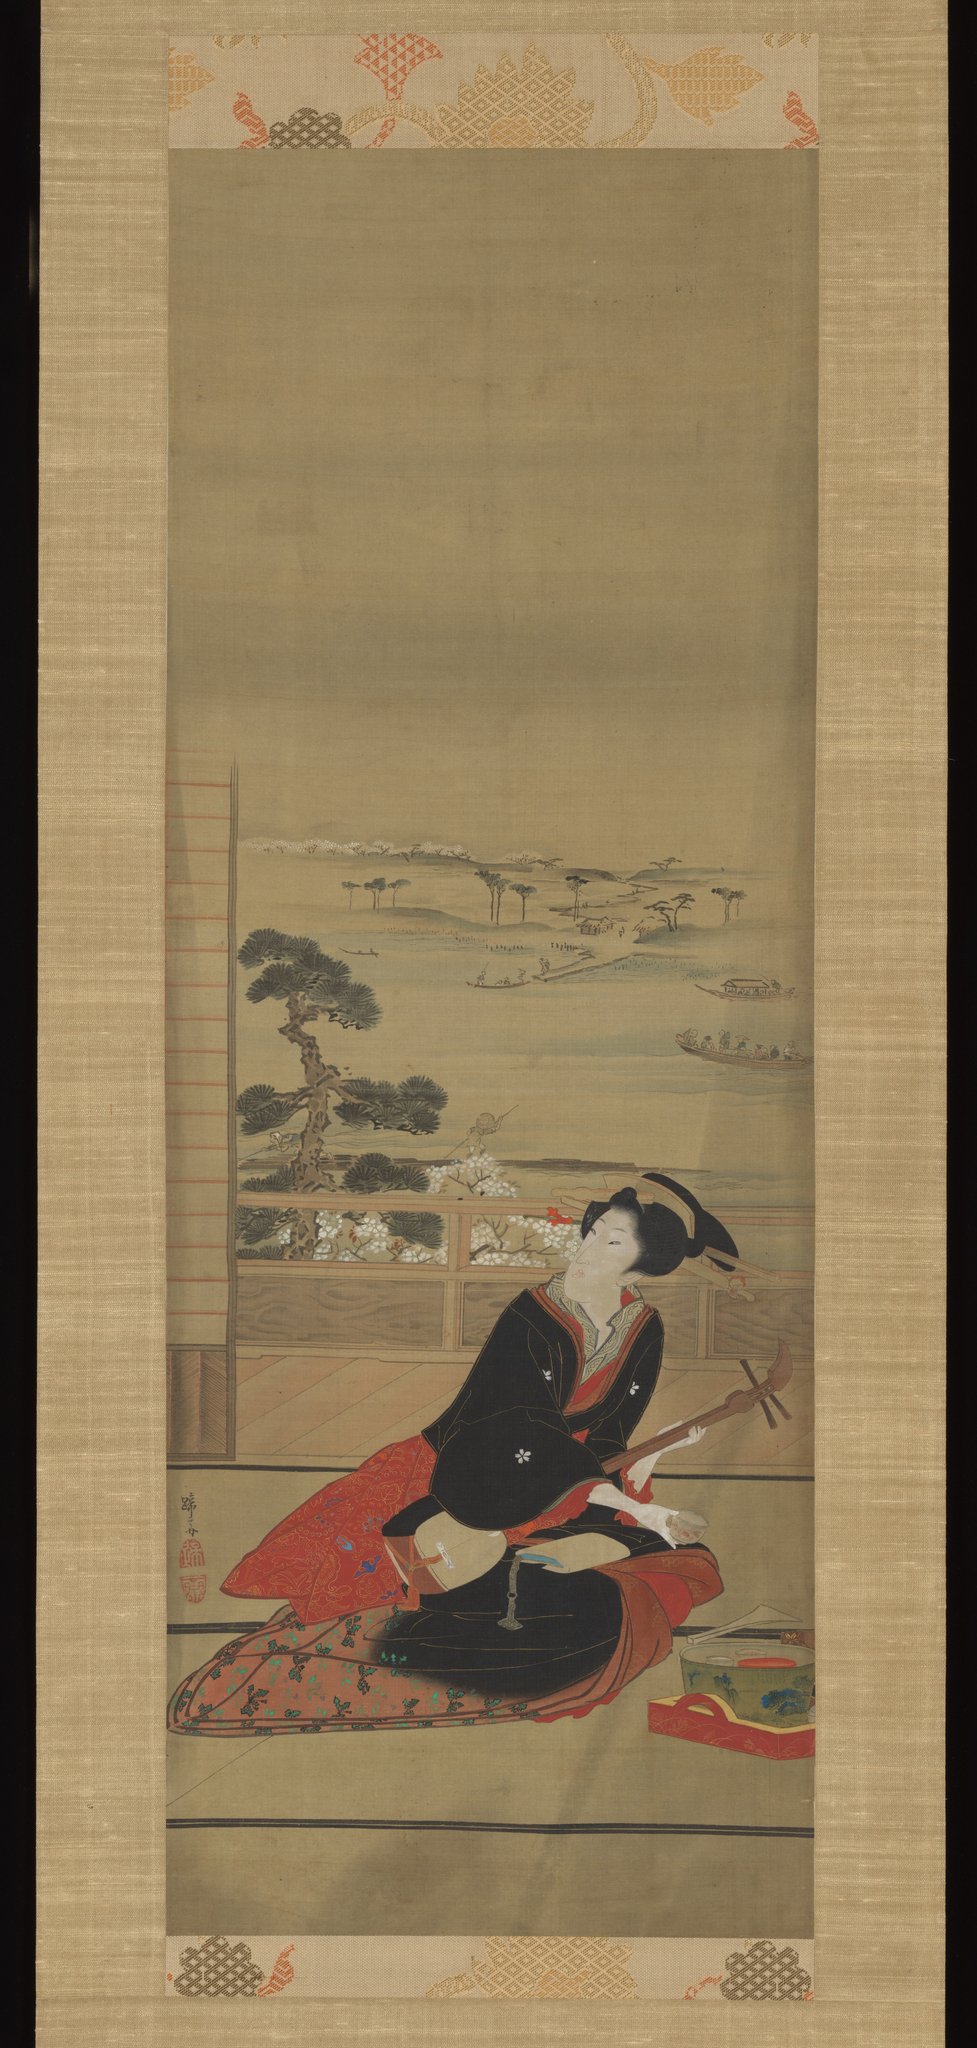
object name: hanging scroll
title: Female Entertainer with Shamisen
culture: japanese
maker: teisai hokuba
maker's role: artist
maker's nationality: japanese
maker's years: 1771-1844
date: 1801-1833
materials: ink, paper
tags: musical instruments,women